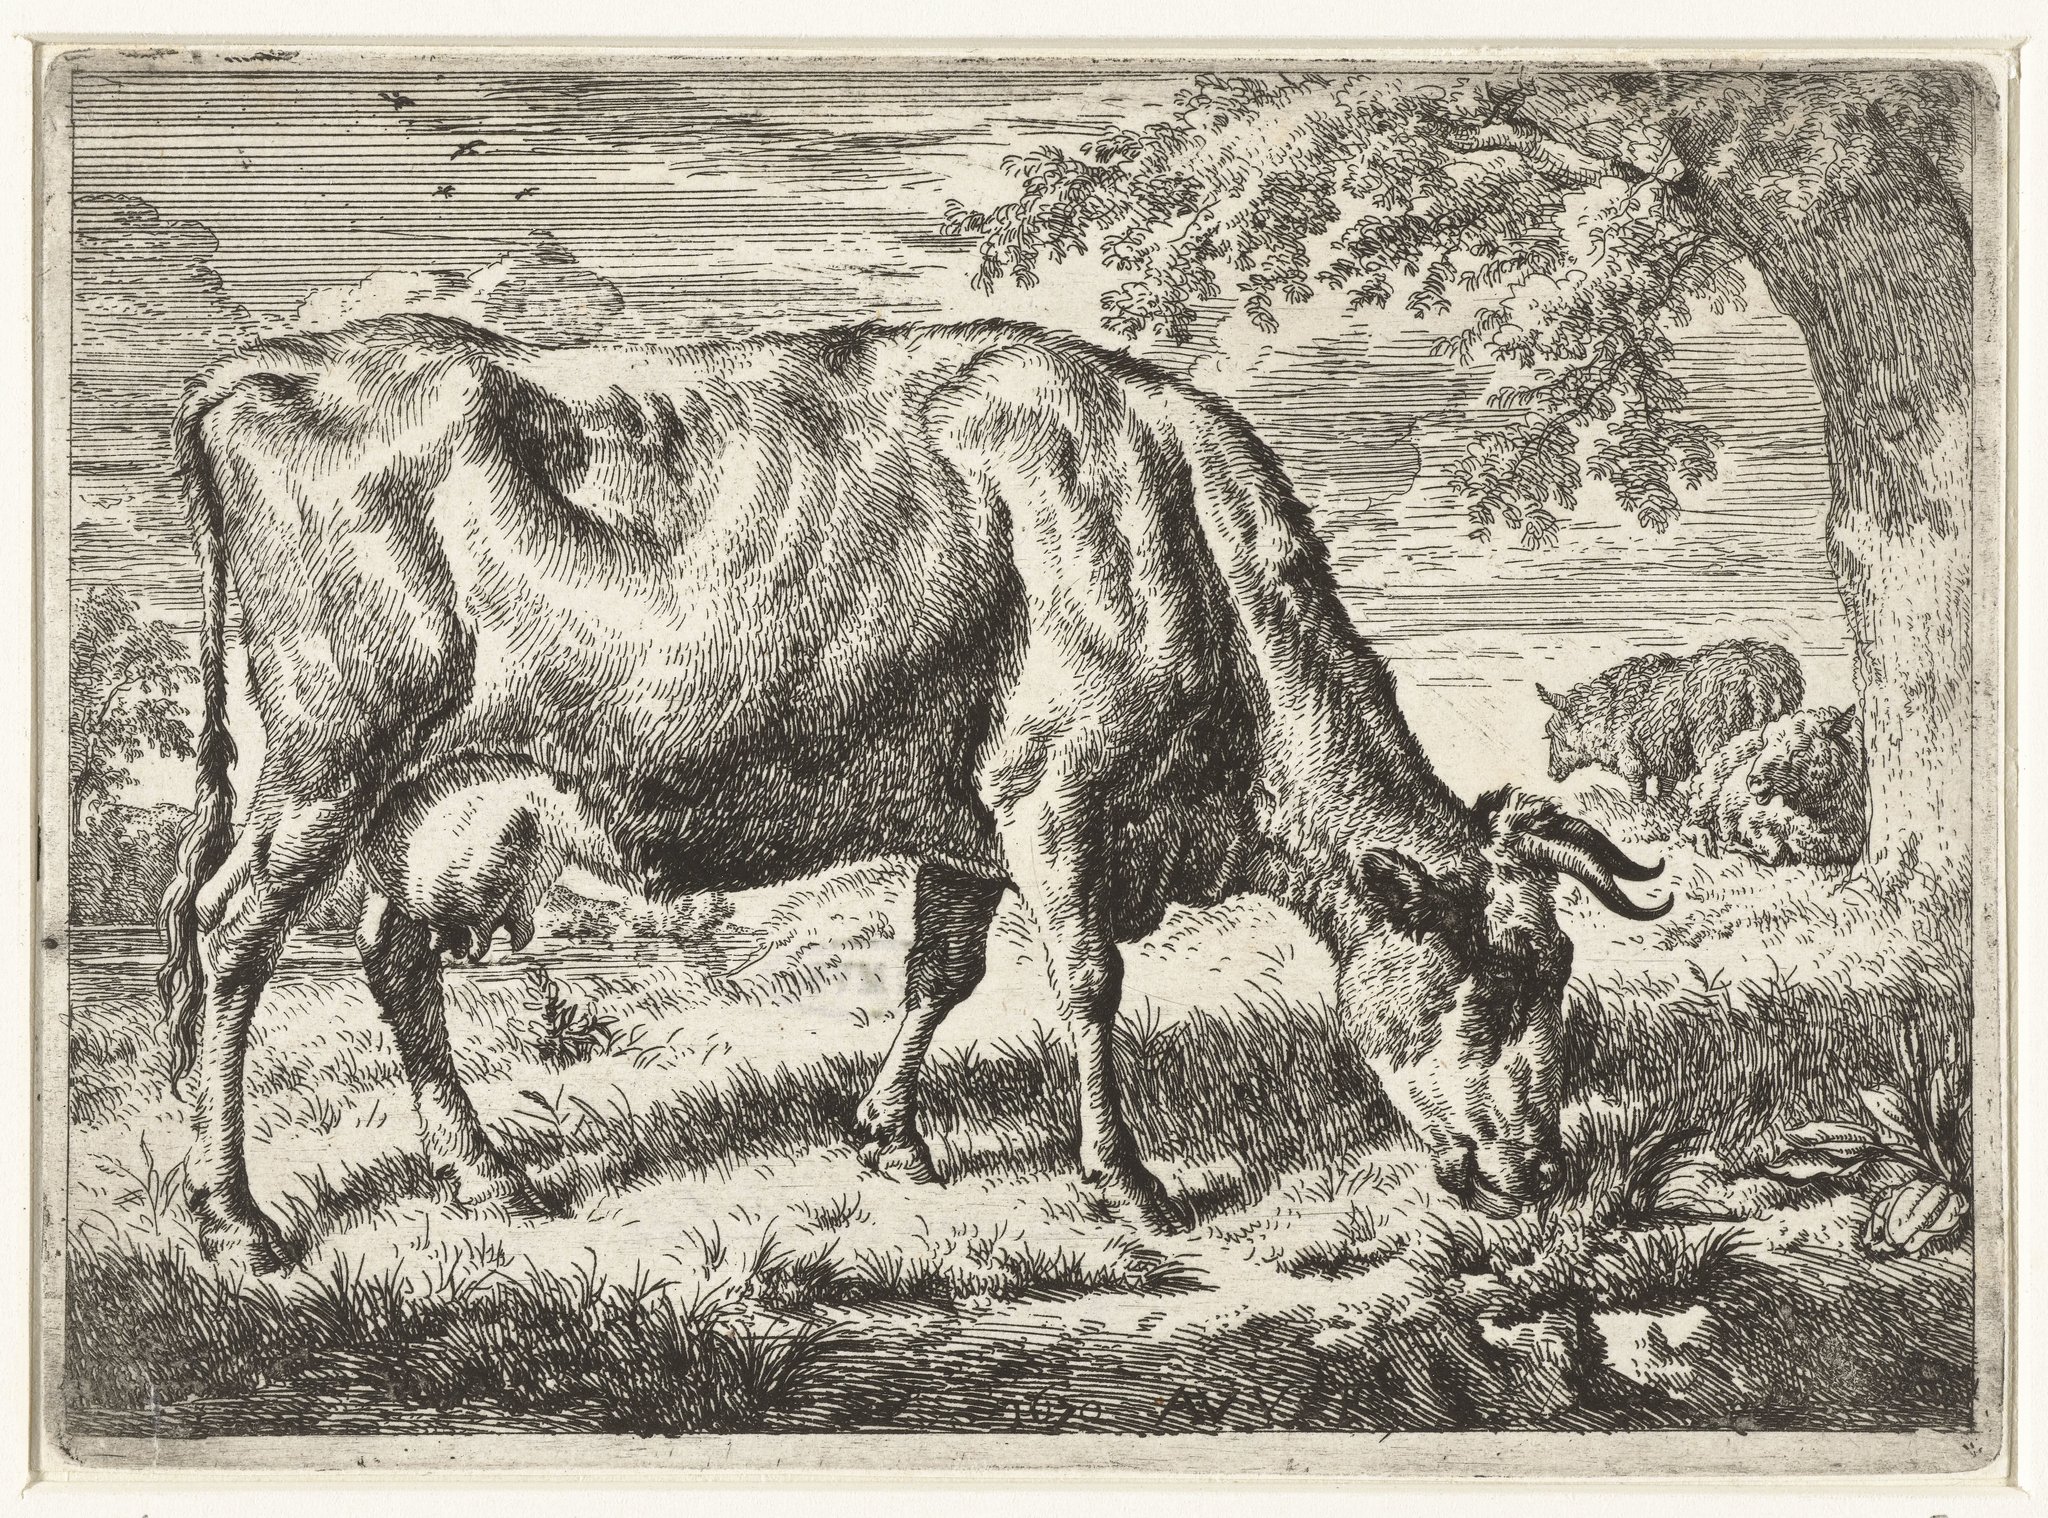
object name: print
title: Grazende koe en twee schapen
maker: adriaen van de velde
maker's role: draughtsman, painter, print maker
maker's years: 1636-1672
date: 1670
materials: paper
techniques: etching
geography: amsterdam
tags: cow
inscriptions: collector's mark: Lugt 2760, collector's mark: Lugt 2228a